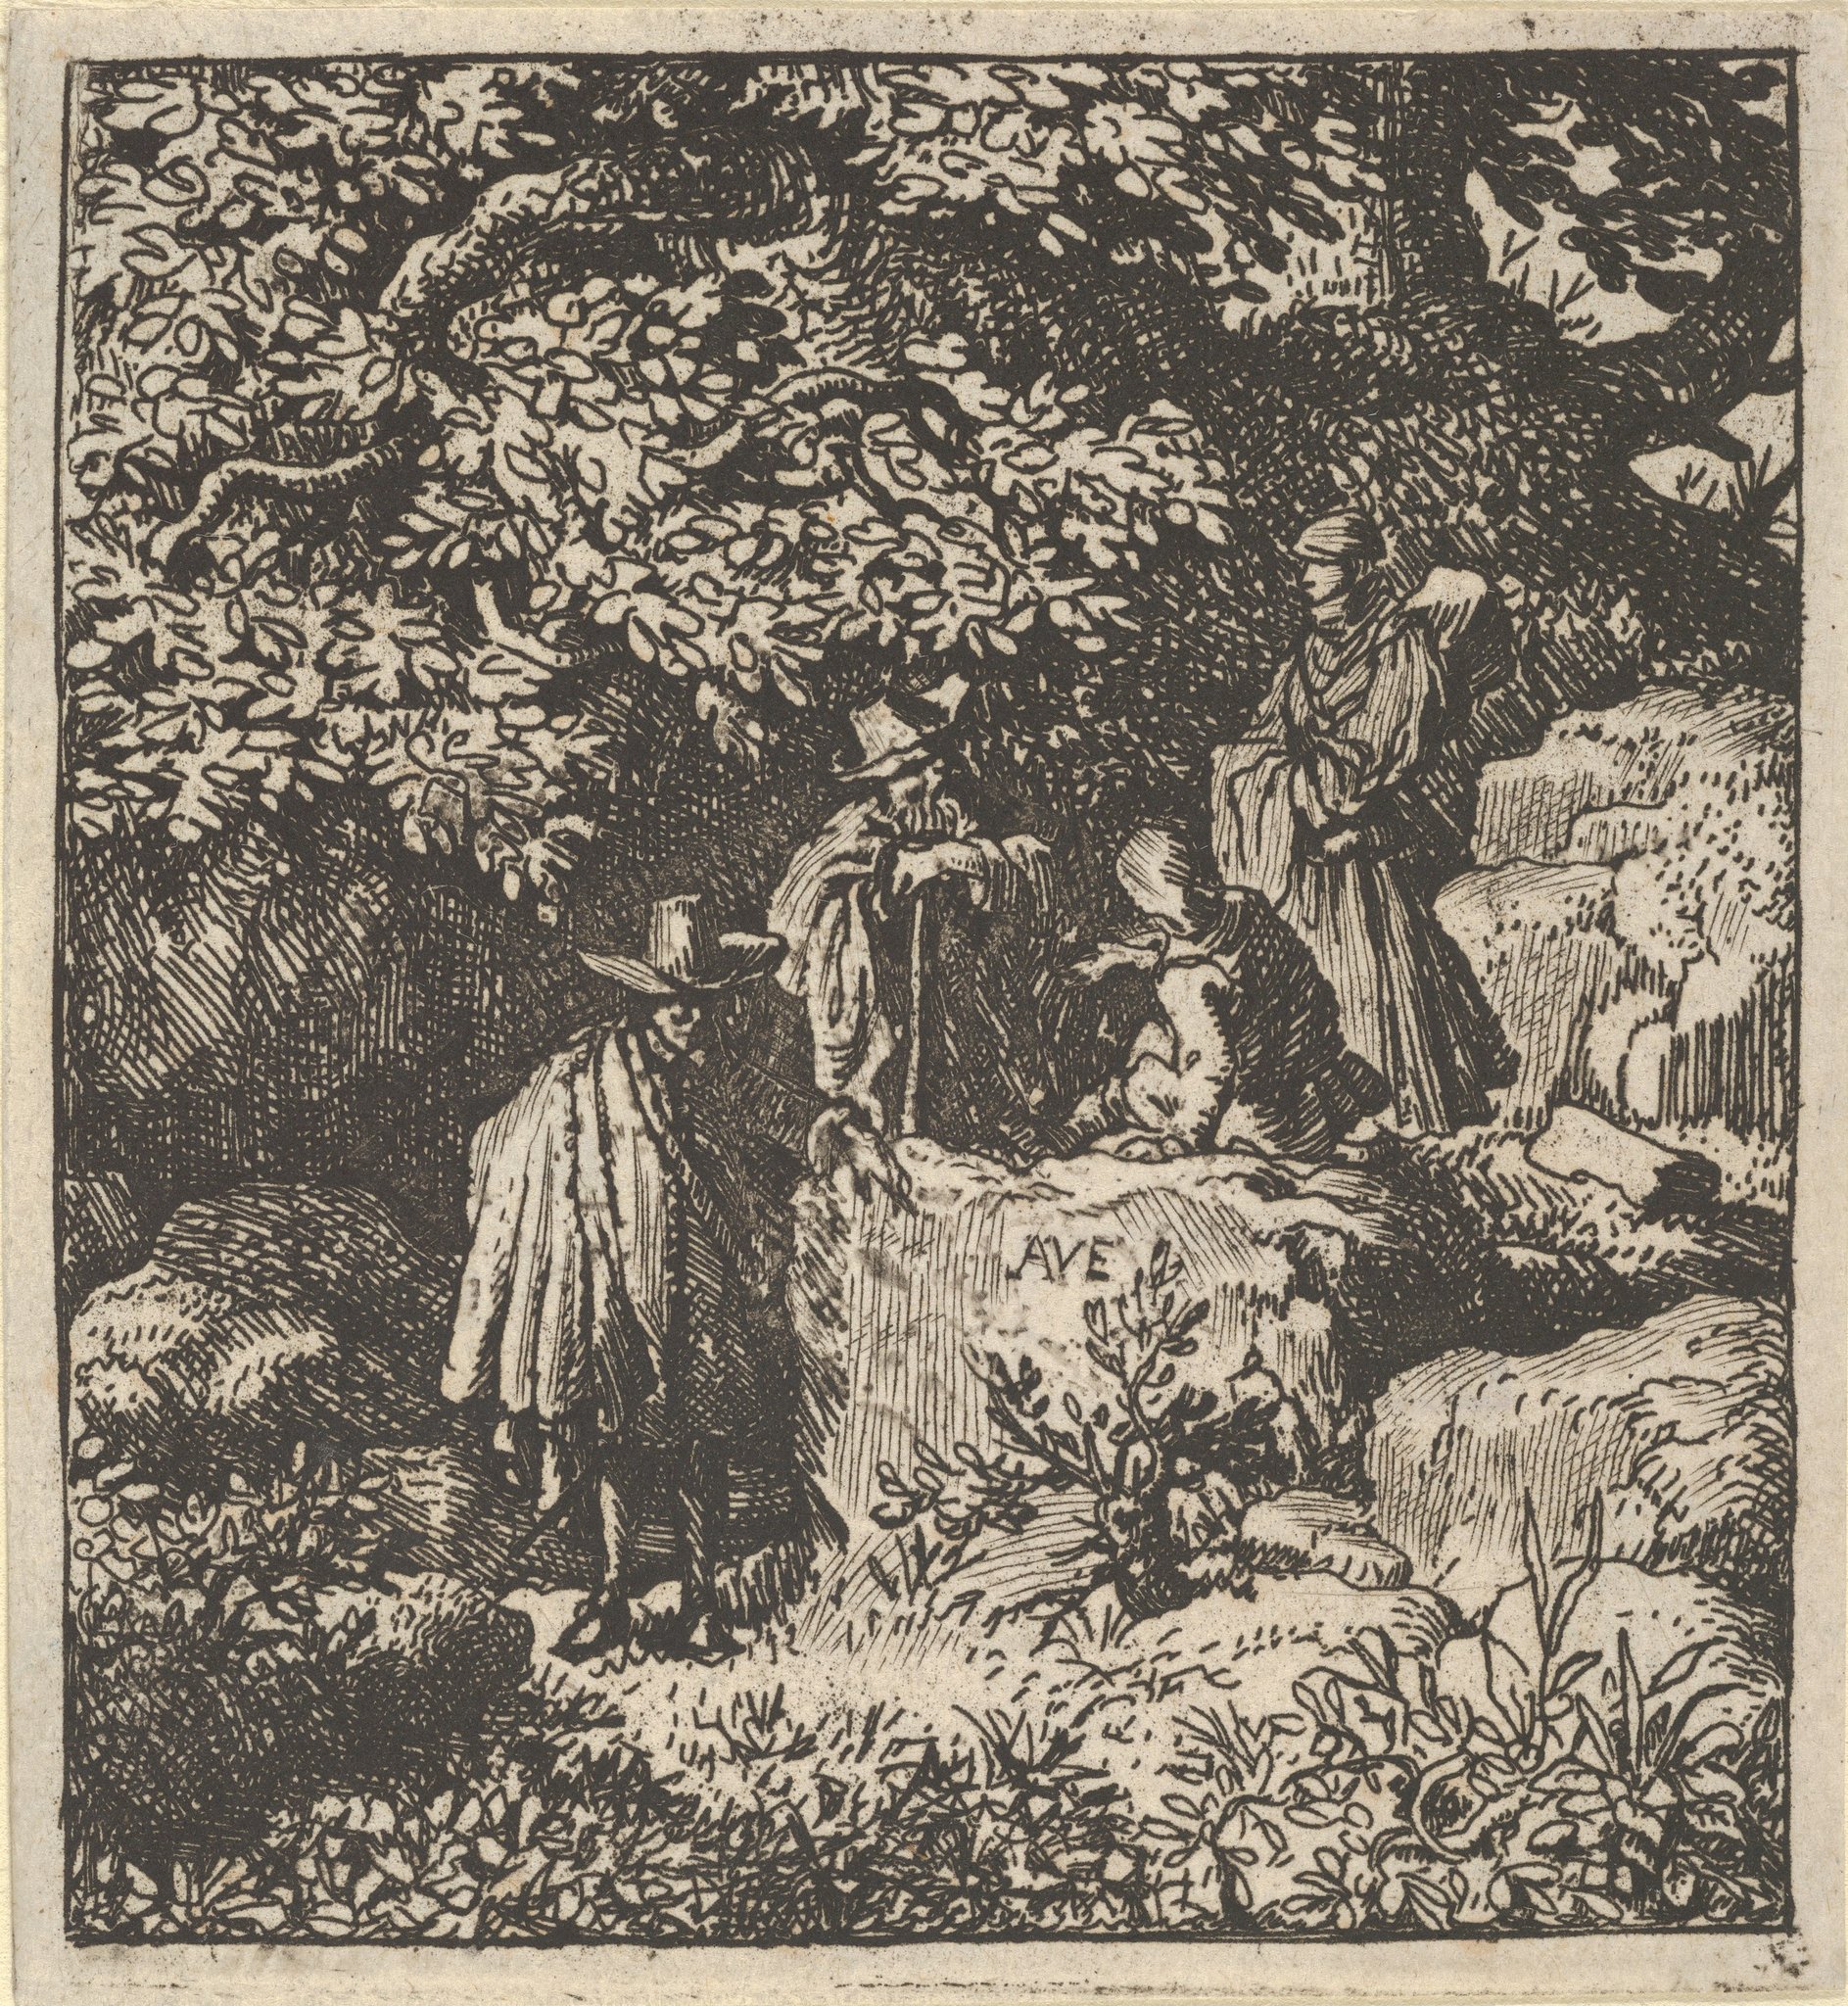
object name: print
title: Four Figures under a Tree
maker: allart van everdingen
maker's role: artist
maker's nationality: dutch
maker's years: 1621-1675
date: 1621-1675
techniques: engraving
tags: men,trees